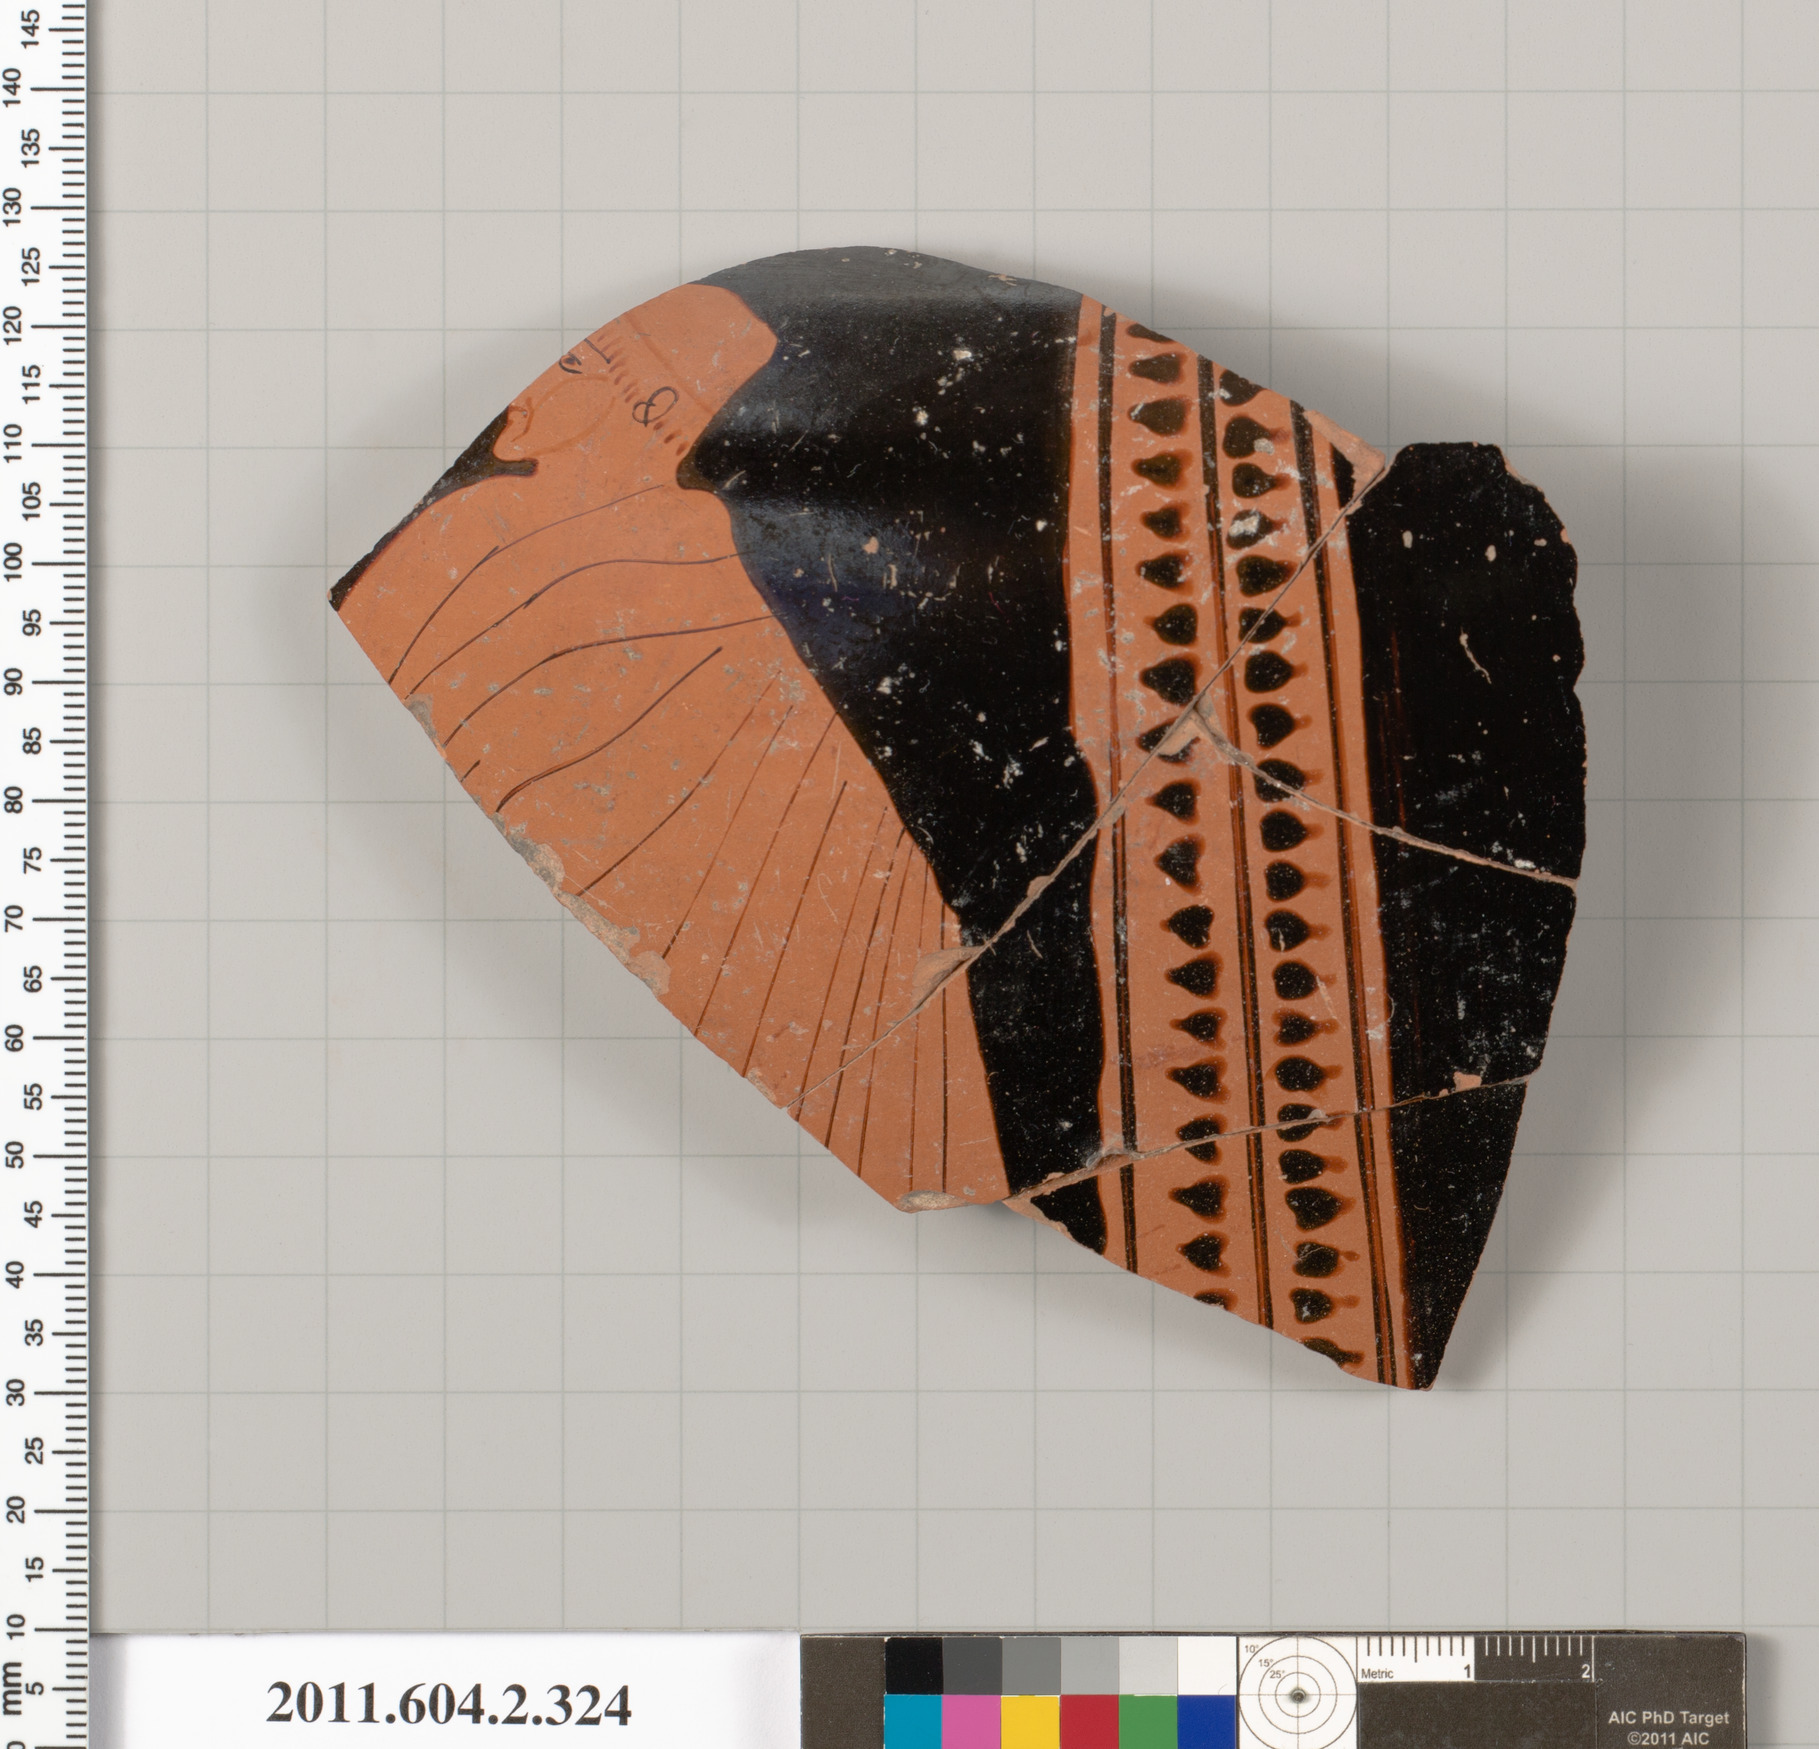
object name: column krater fragment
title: Terracotta fragment of a column-krater (bowl for mixing wine and water)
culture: greek, attic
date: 460-440 BCE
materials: terracotta